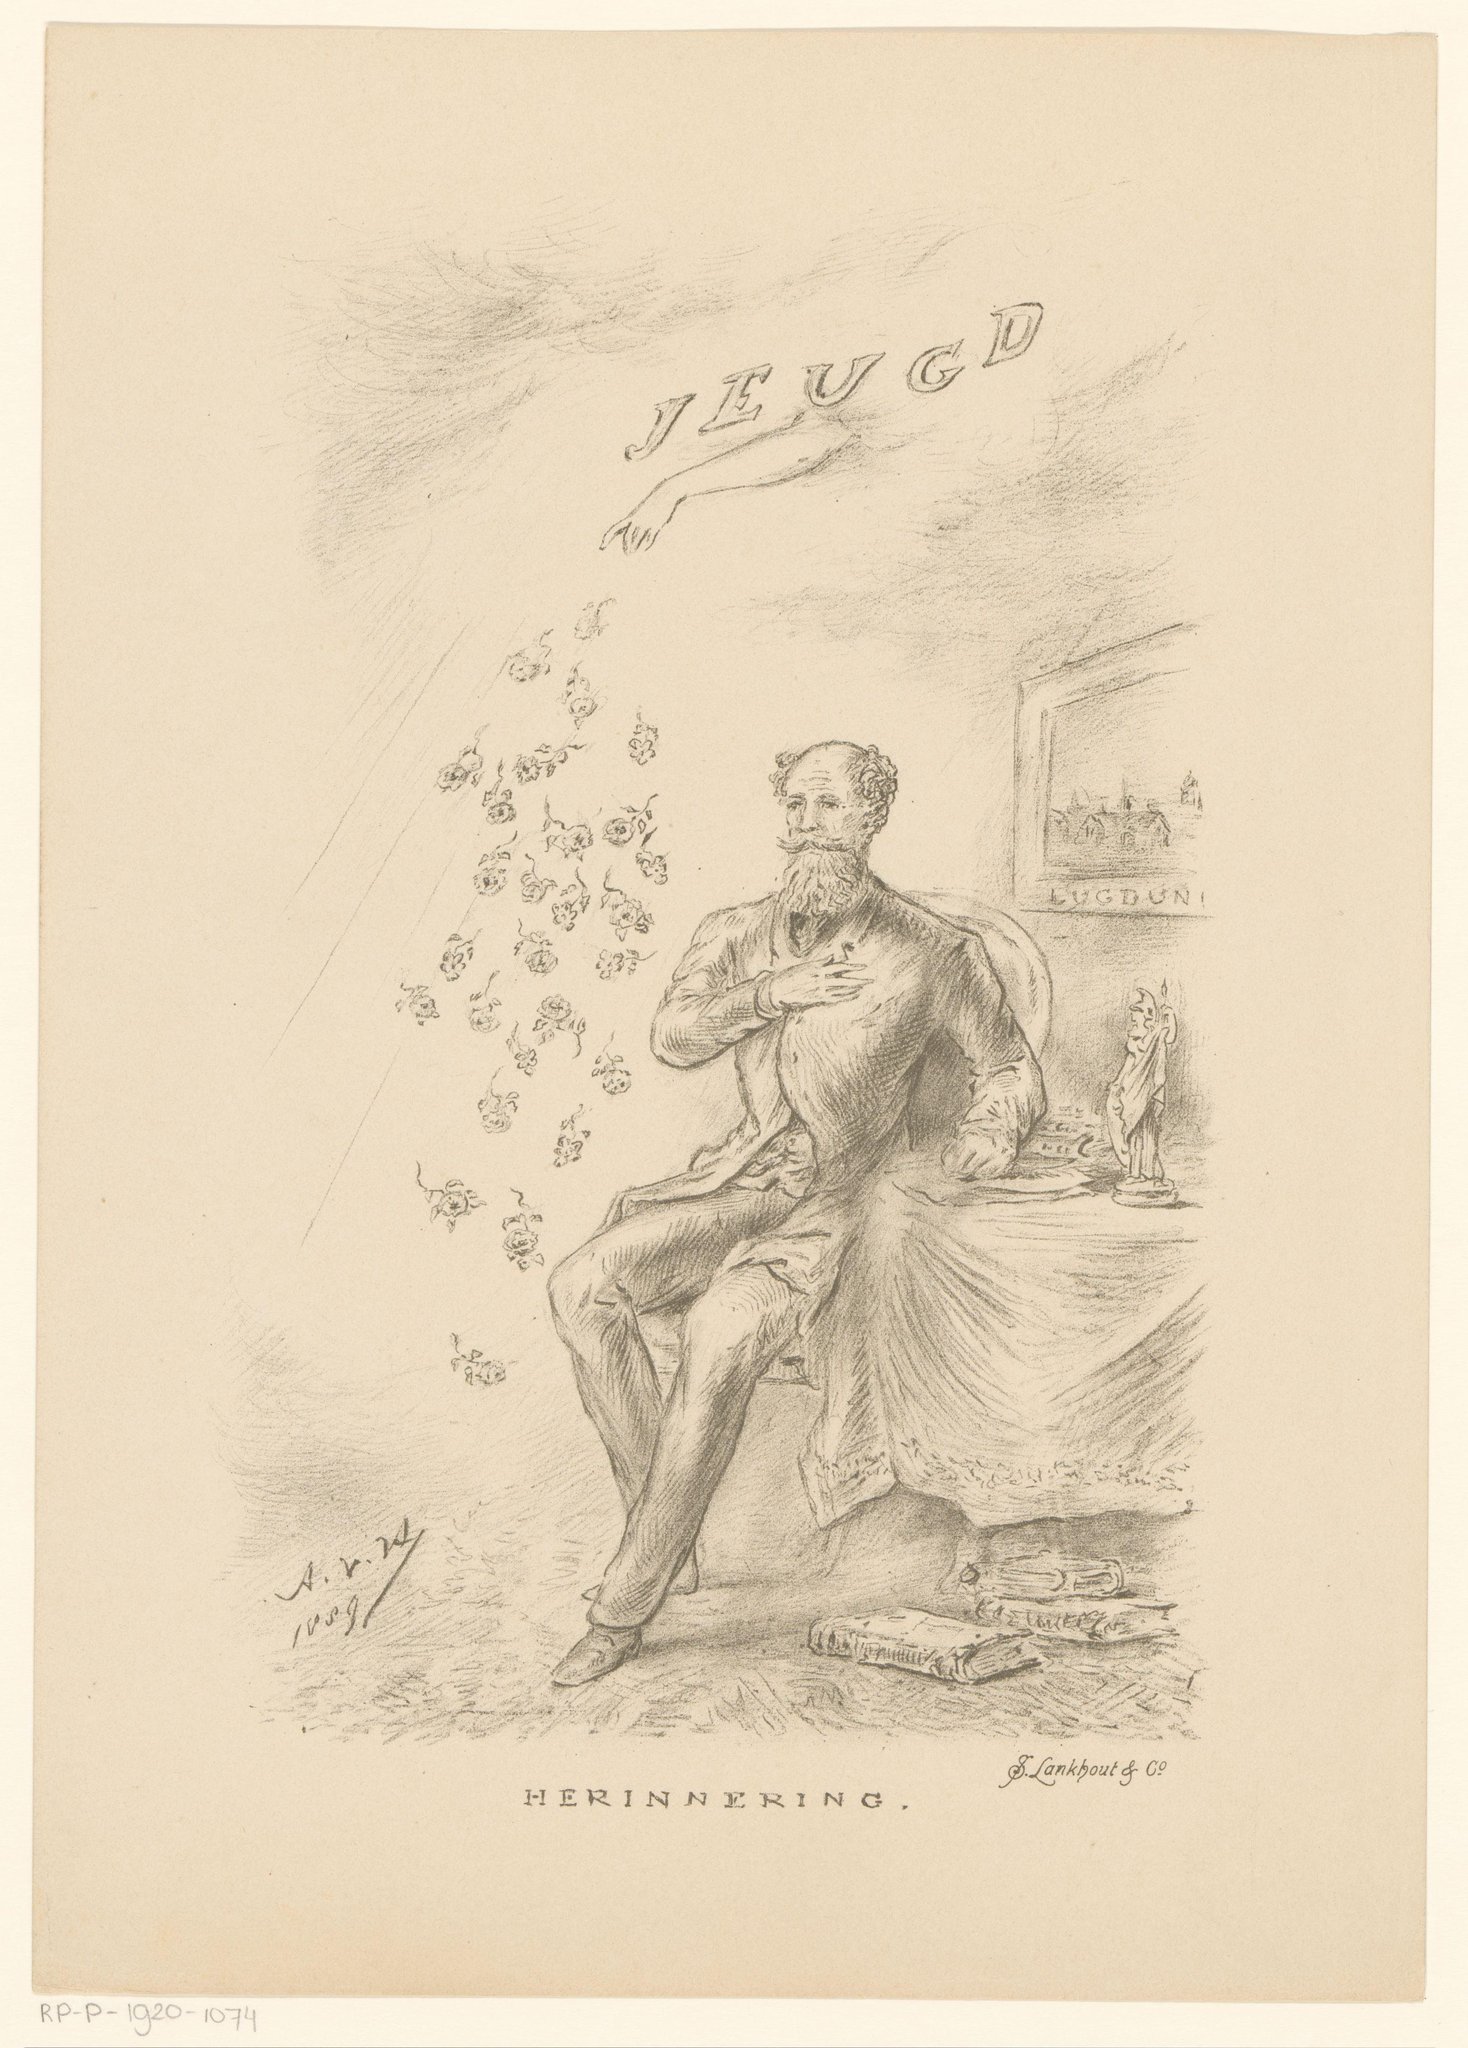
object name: print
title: Jeugd herinnering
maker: alexander ver huell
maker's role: draughtsman, print maker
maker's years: 1822-1897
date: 1889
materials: paper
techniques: lithograph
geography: the hague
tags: old man, memory; 'memoria' (ripa)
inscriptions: collector's mark: Lugt 2228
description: Een oude man zit aan tafel met zijn hand op zijn borst. Vanuit de lucht verschijnt een arm uit de wolken en strooit rozen. Bij de man een beeld van Minerva en een schilderij met gezicht op leiden.